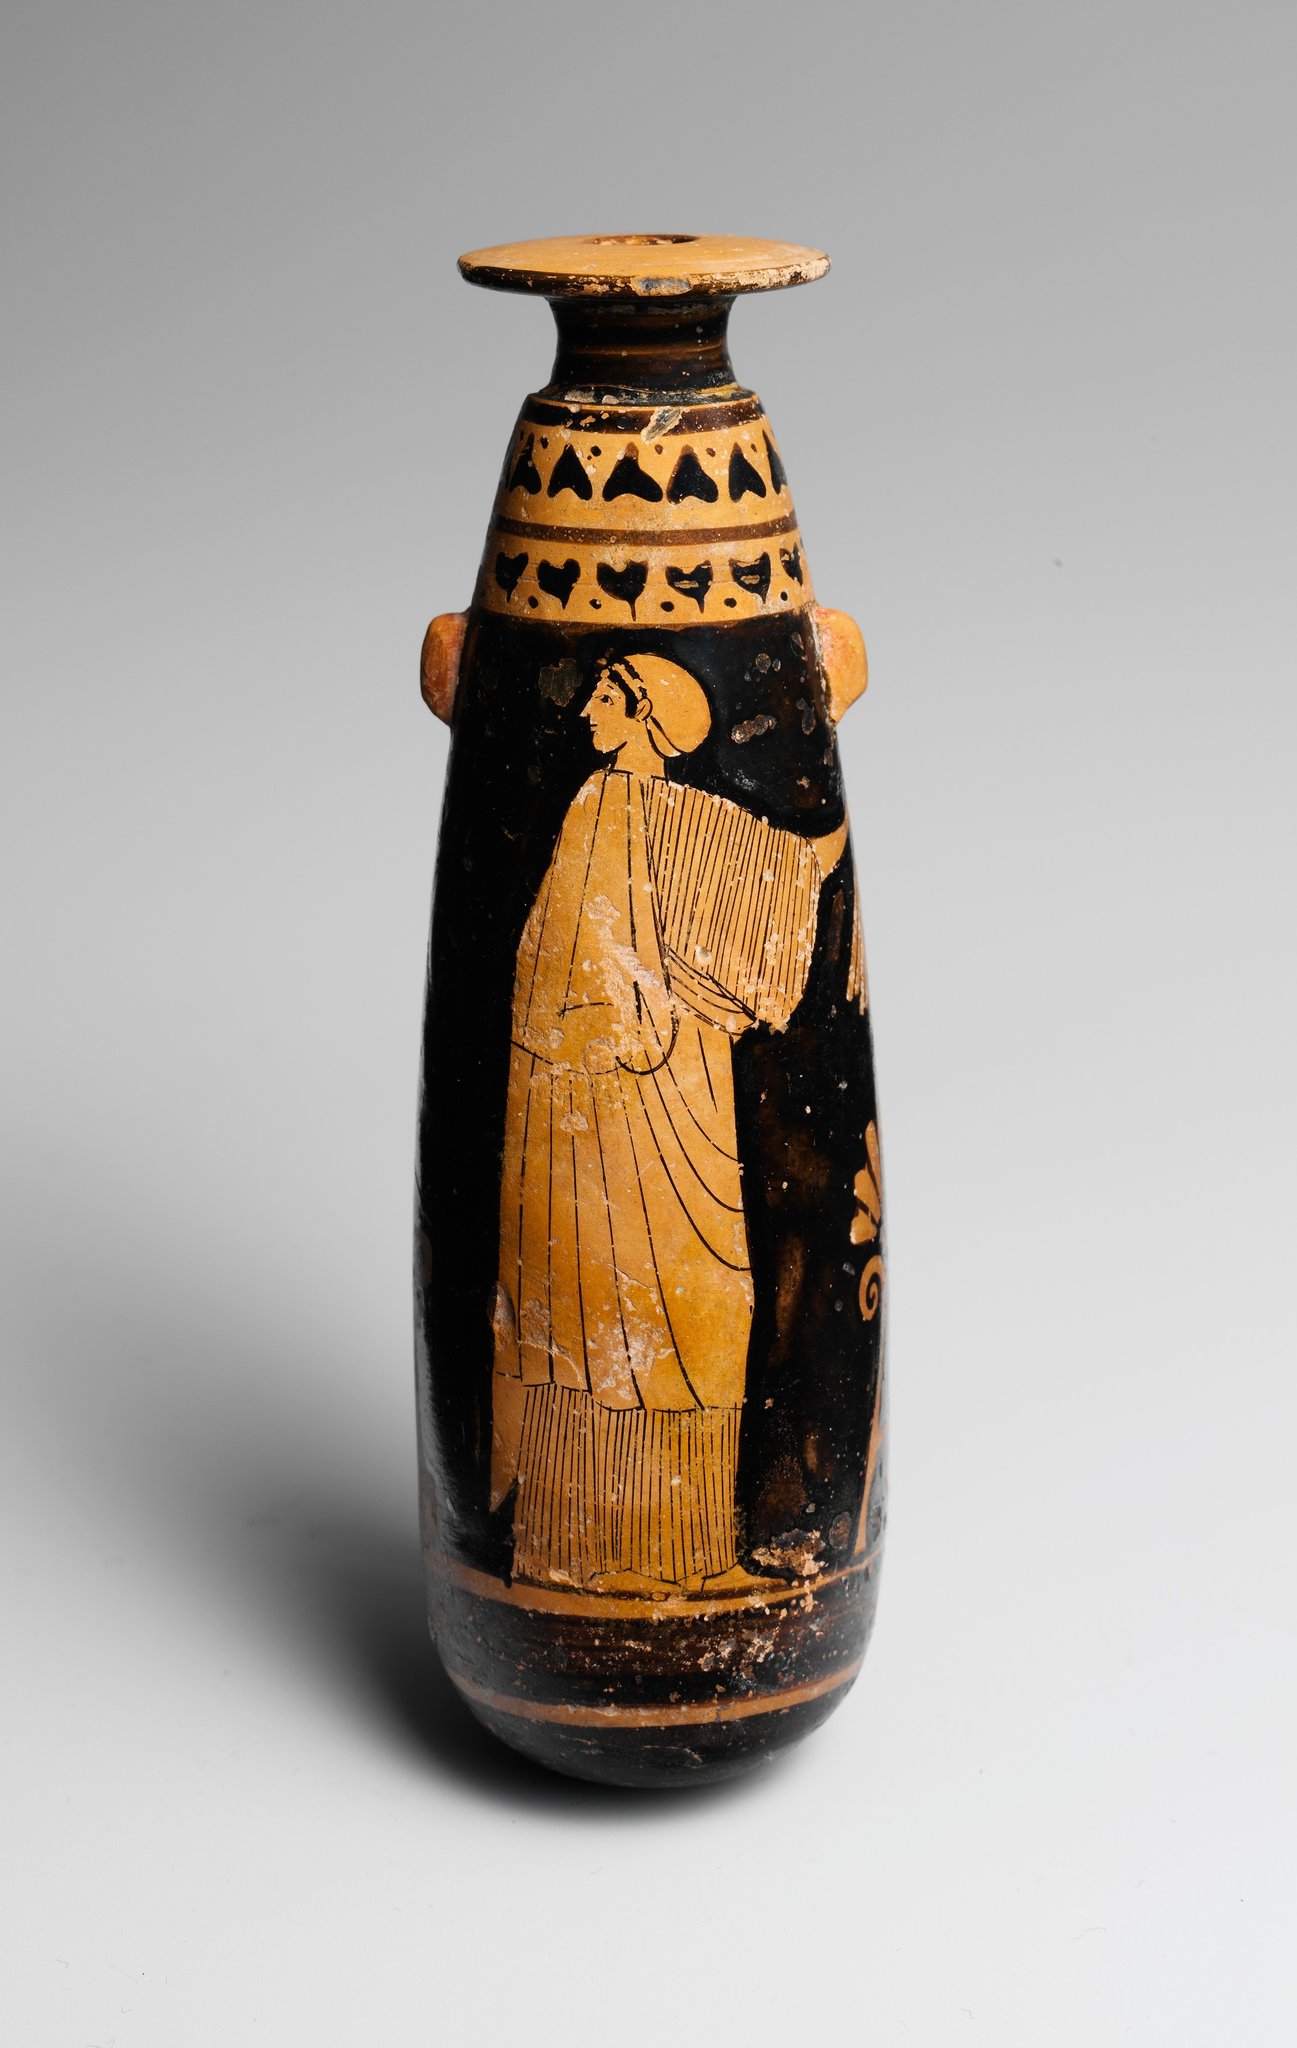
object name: alabastron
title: Terracotta alabastron (perfume vase)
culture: greek, attic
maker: painter of palermo 1162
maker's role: artist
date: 480 BCE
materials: terracotta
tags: women,nike